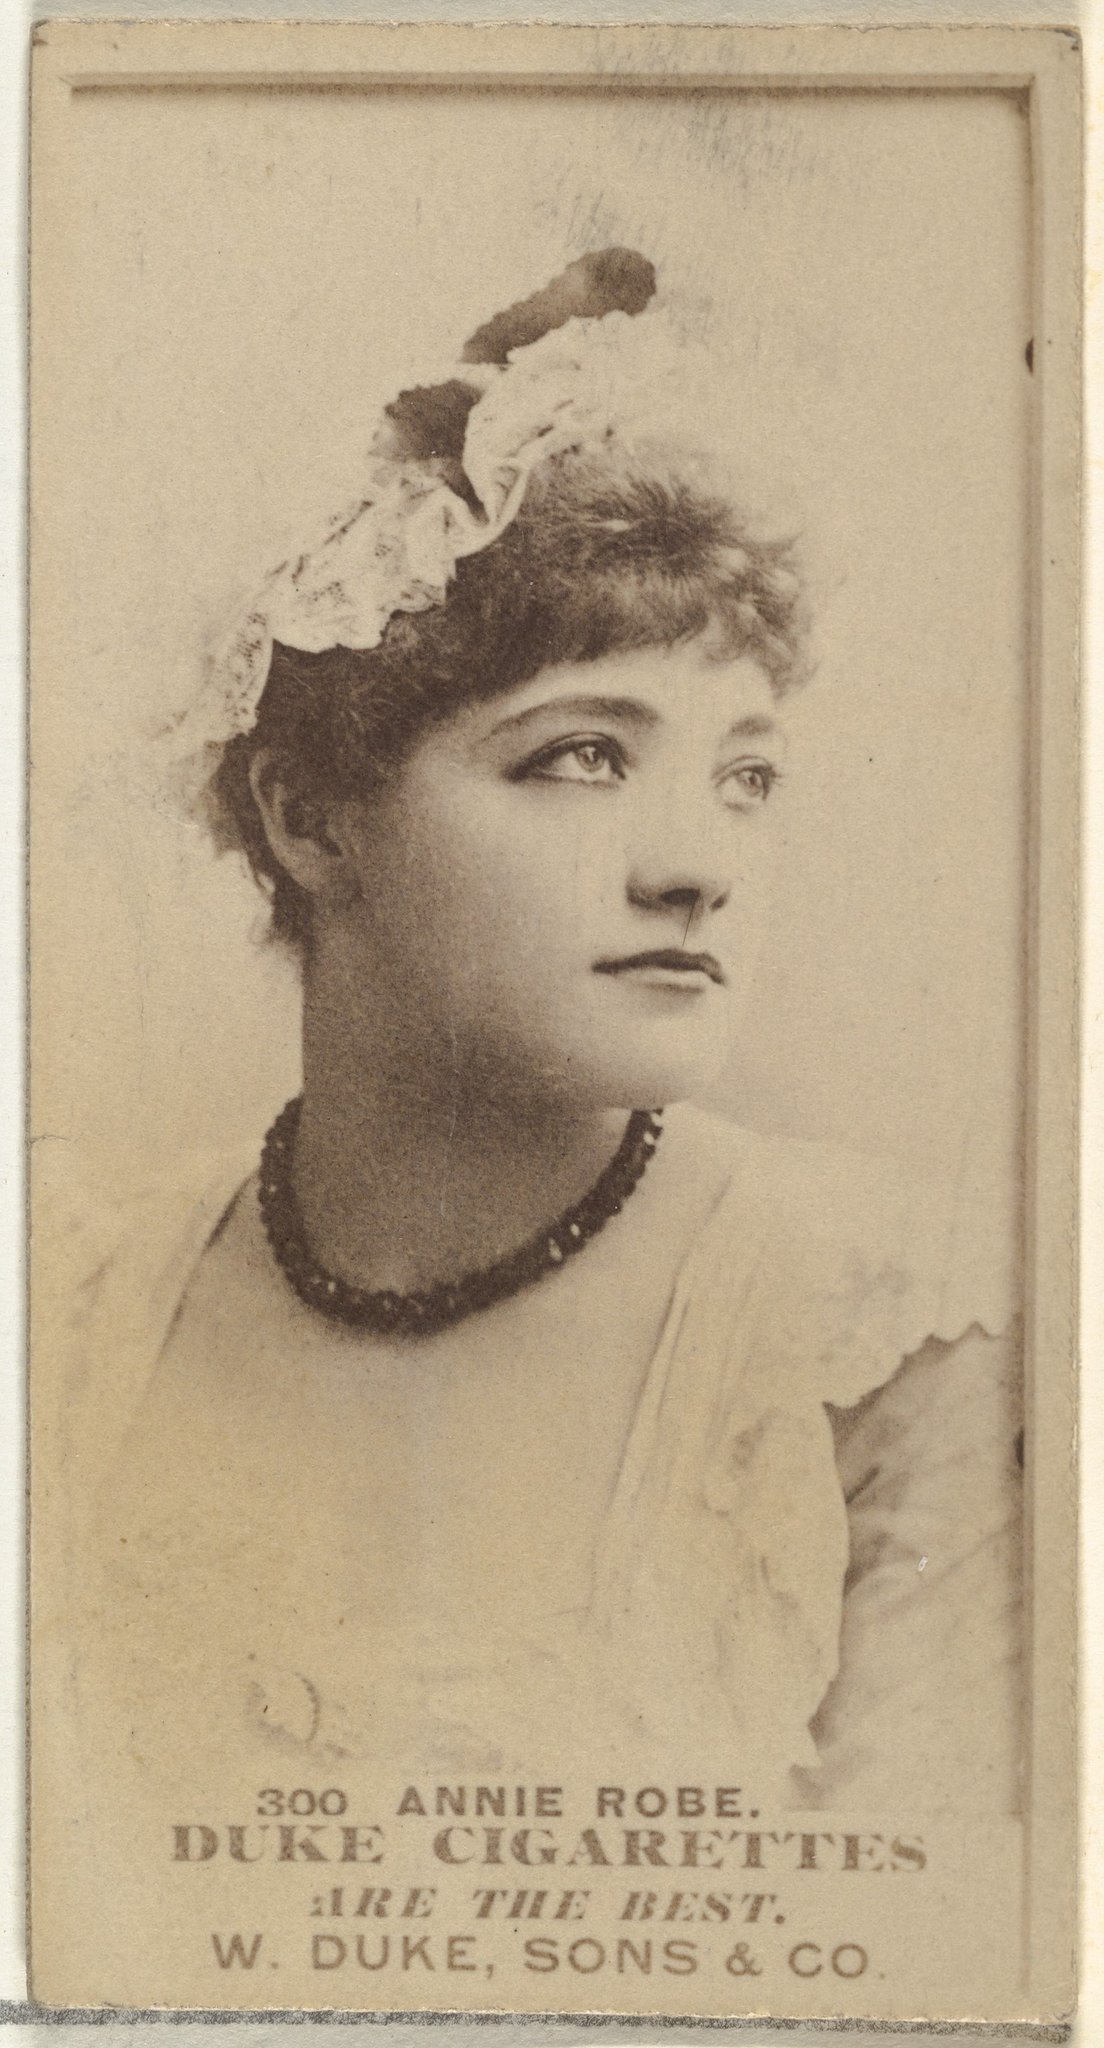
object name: photograph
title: Card Number 300, Annie Robe, from the Actors and Actresses series (N145-7) issued by Duke Sons & Co. to promote Duke Cigarettes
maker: w. duke, sons & co.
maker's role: publisher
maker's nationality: american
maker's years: 1870-1920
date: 1880-1889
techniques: albumen silver print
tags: portraits,women,actresses